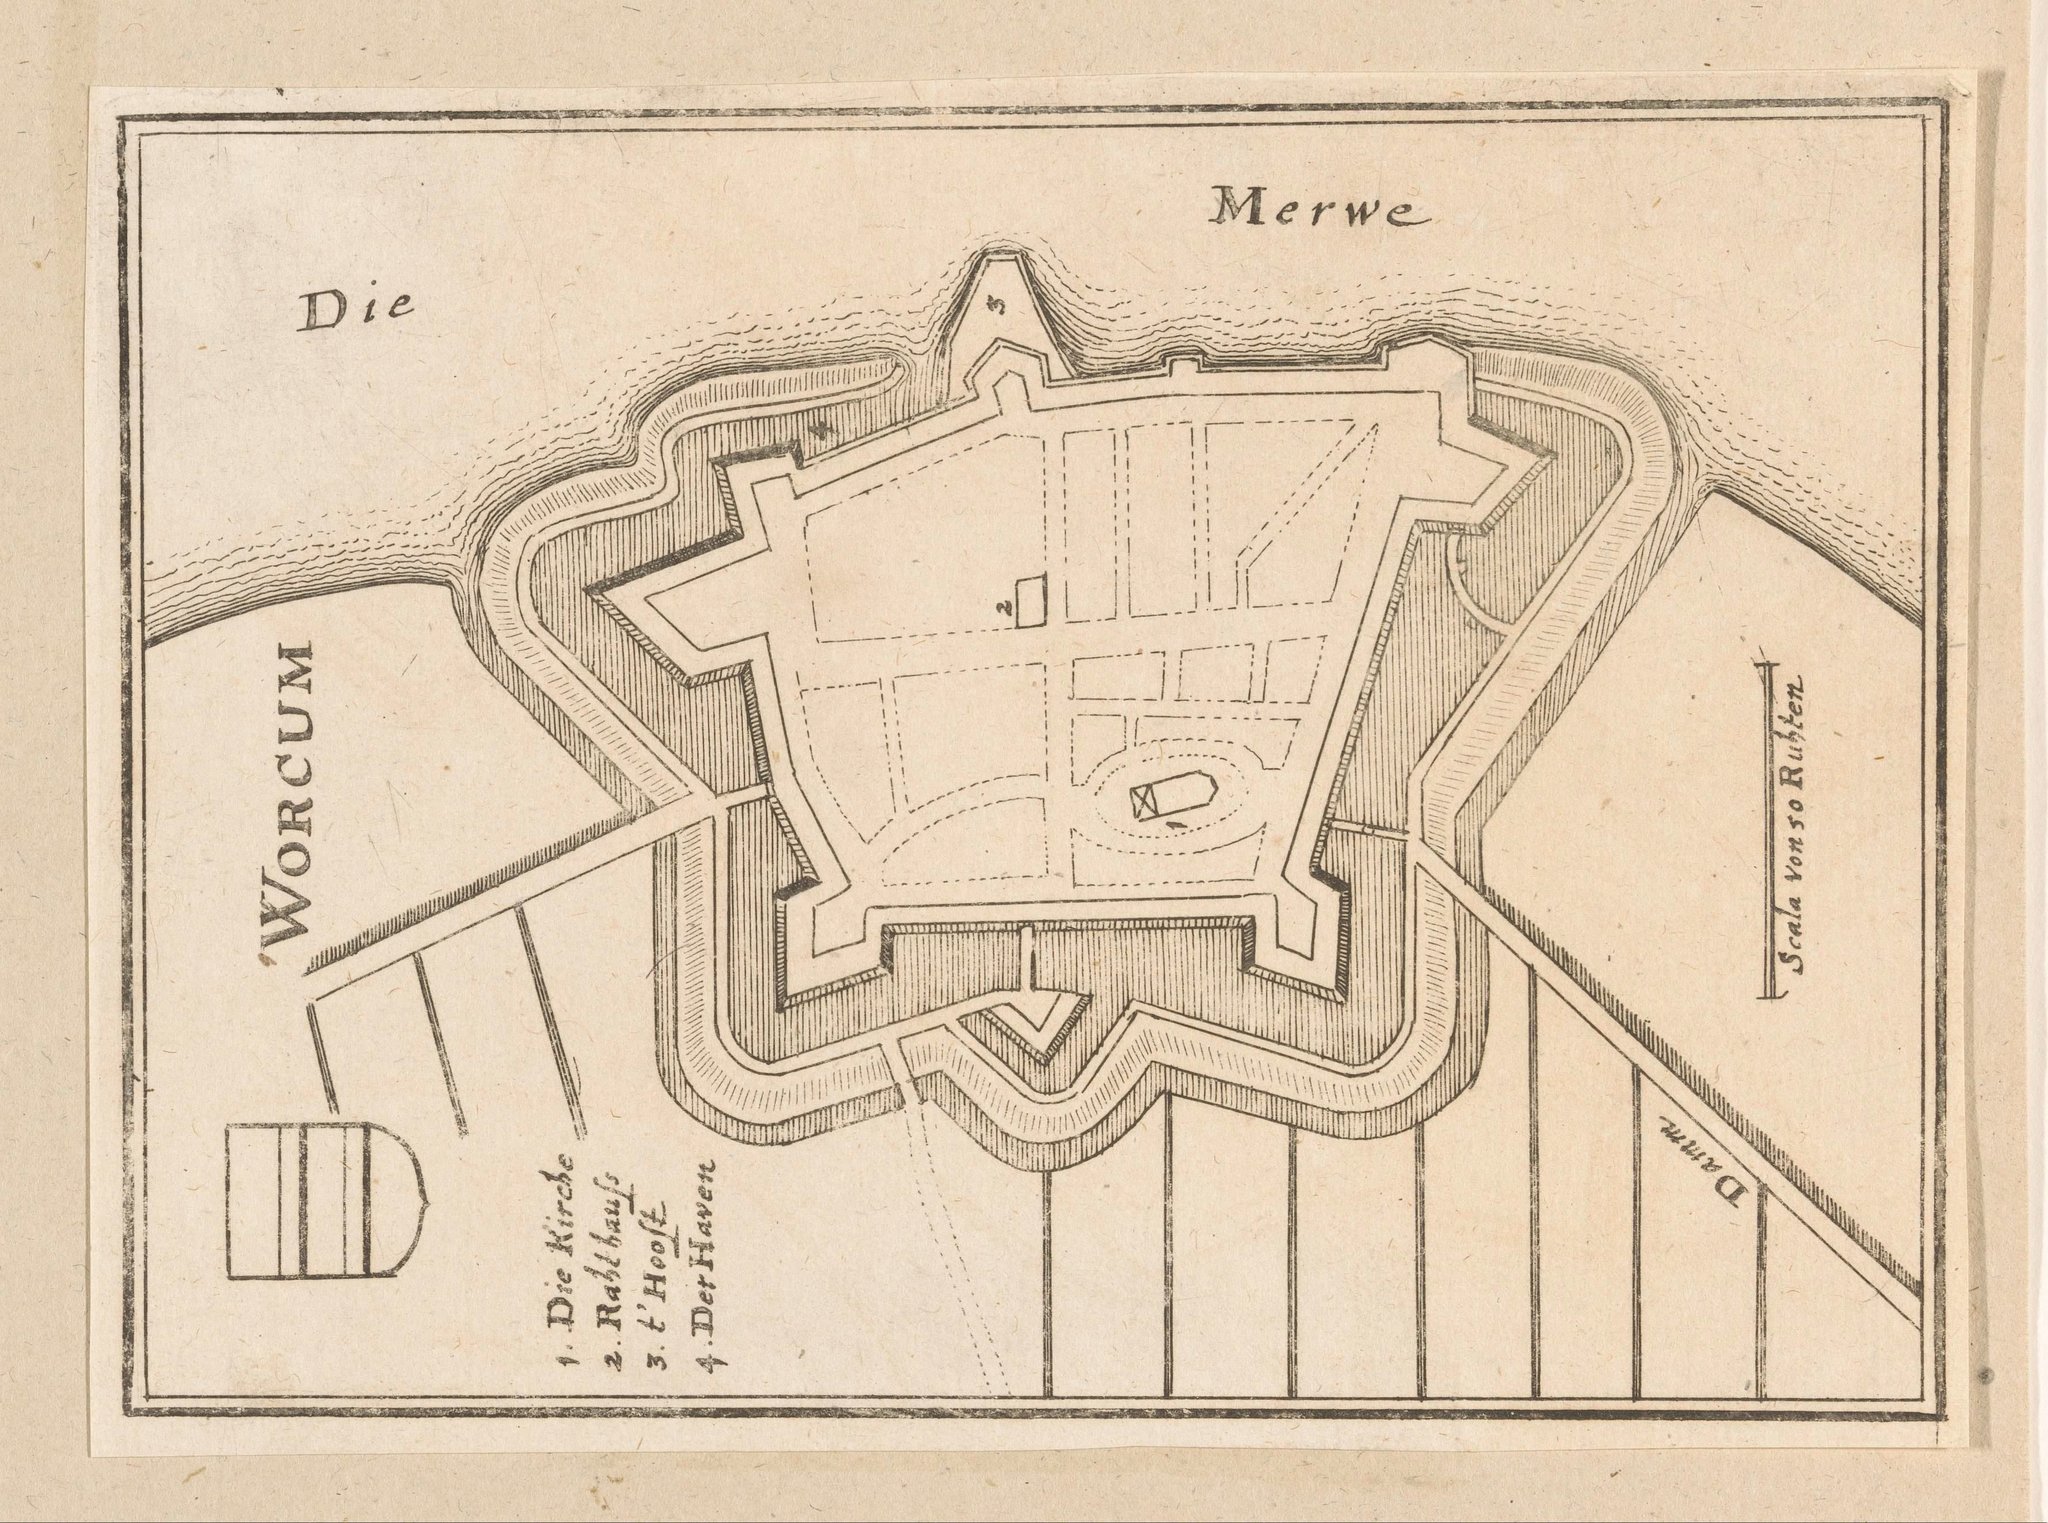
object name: print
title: Worcum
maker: caspar merian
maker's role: print maker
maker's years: 1627-1689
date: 1654-1700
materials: paper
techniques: etching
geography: frankfurt am main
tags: coat of arms (as symbol of the state, etc.) (+ city; municipal), fortified city, maps of cities, woudrichem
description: Prent gebruikt in: Zeiller, Martin. M.Z. Topographia Circuli Burgundici Oder Beschreibung une Eigentliche Abbildung der Vornehmsten Örter in dem Hochlöblichen Burgund- un Niderlandischen Crayse. Frankfurt am Main: Caspar Merian, 1654. Of in: Zeiller, Martin. M. Z. Topographia Germaniae-Inferioris vel Circuli-Burgundici, das ist Beschreibung (…). Frankfurt am Main: Caspar Merian, 1659. Of in een van de twee latere uitgaven van deze publicatie die, hoewel het jaar 1659 erin staat vermeld als jaar van uitgave, zijn uitgegeven in respectievelijk ca. 1670 en ca. 1700.